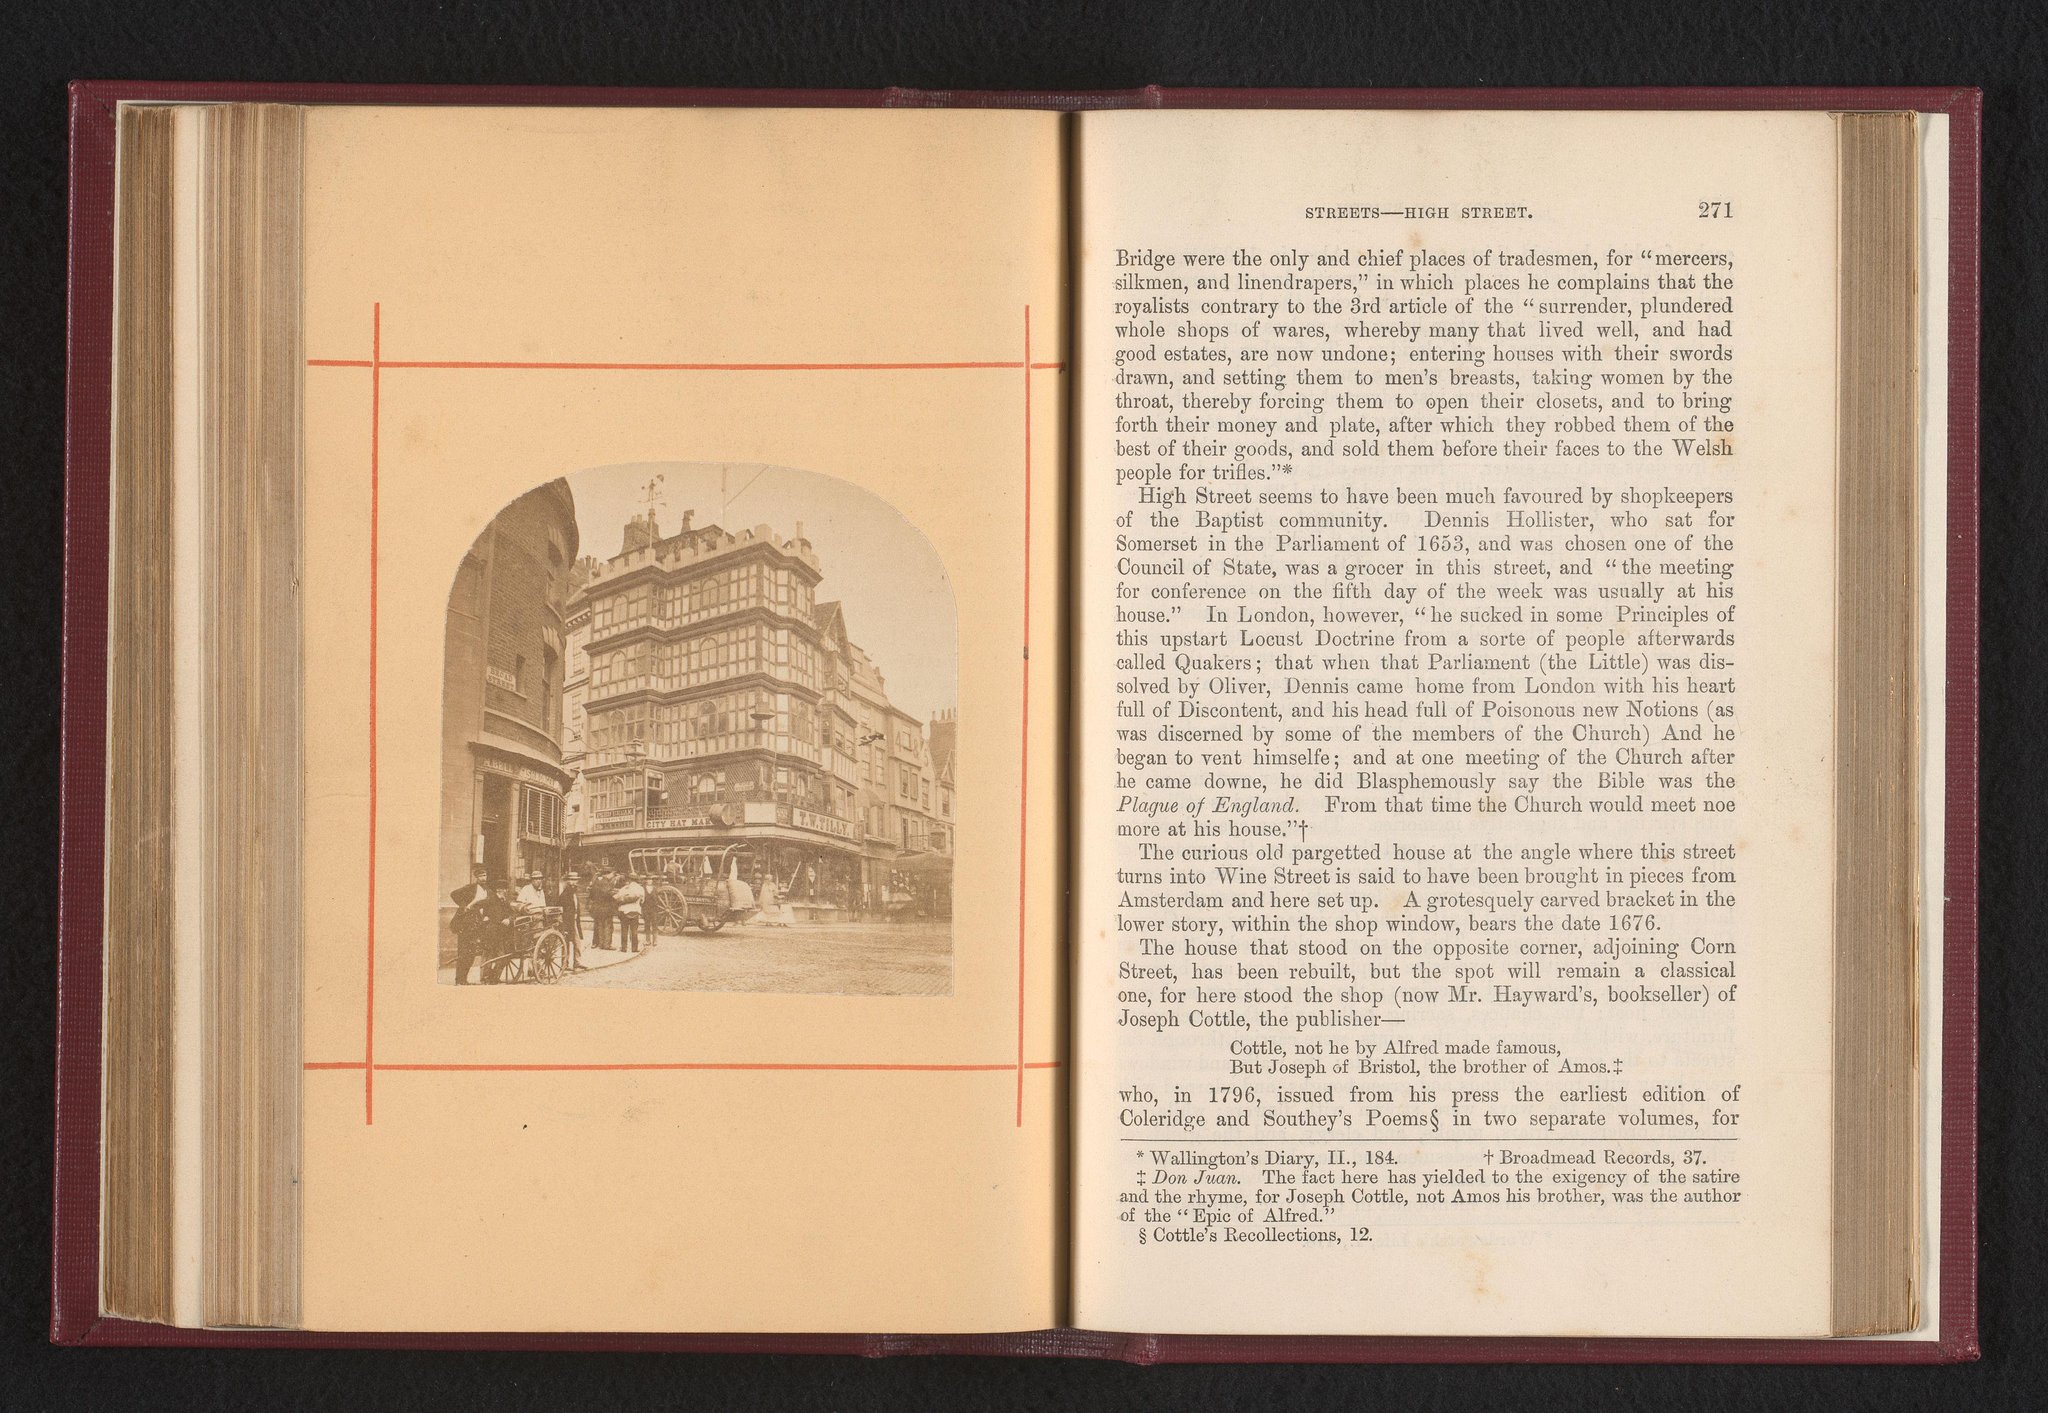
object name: page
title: Gezicht op Bristol's High Street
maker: Anonymous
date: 1867-1872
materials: photographic support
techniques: albumen print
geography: bristol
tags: civic architecture; edifices; dwellings, street